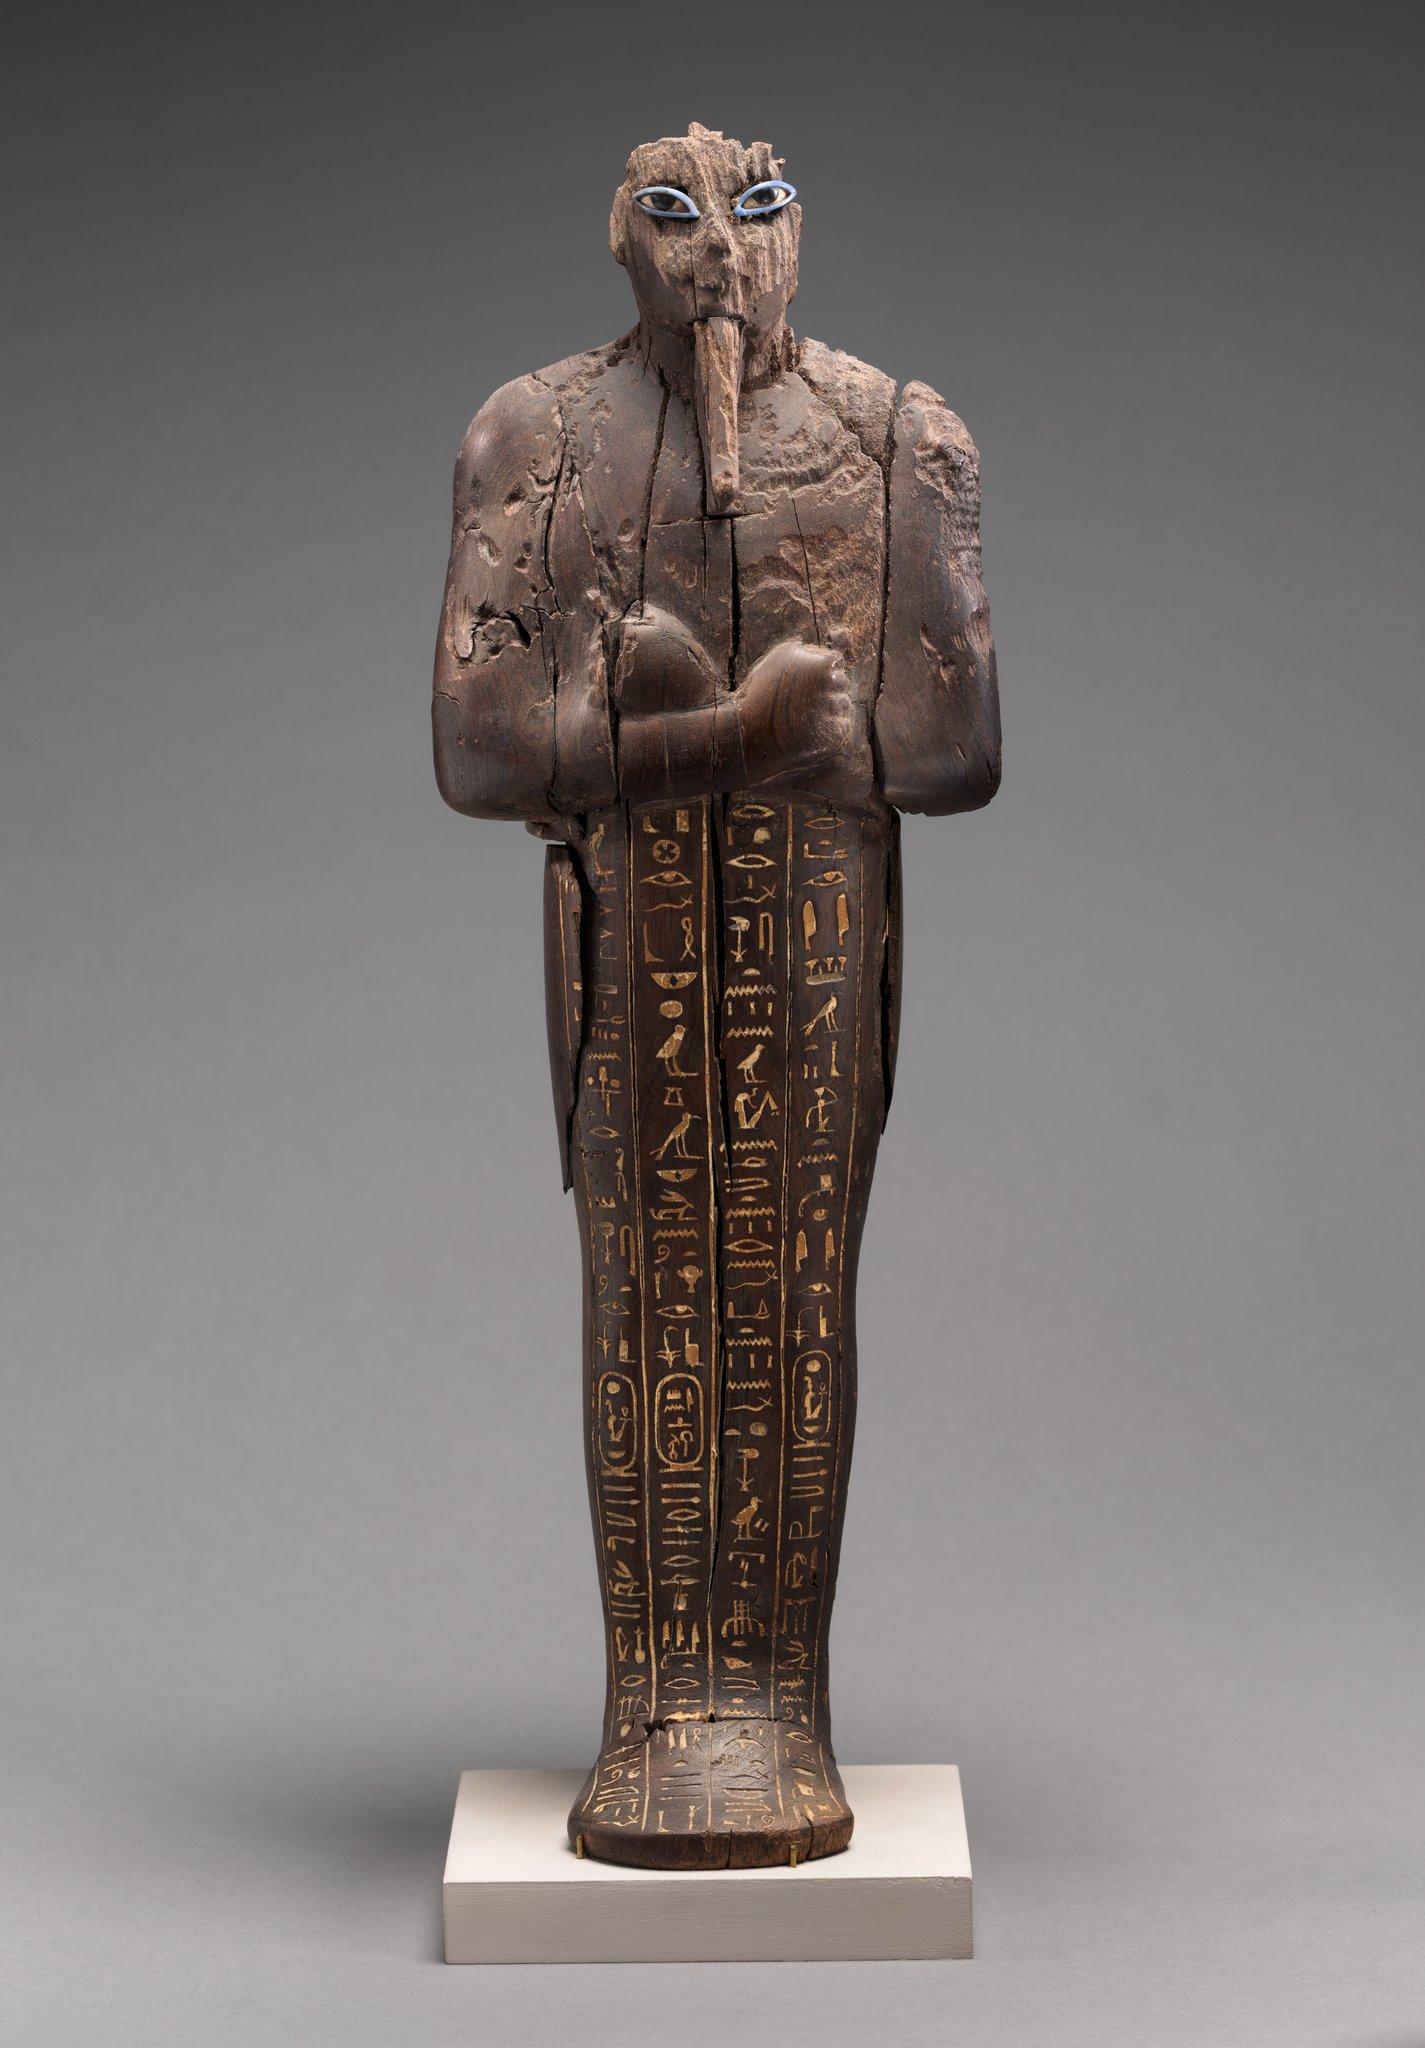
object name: shabti, amenhotep iii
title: Shabti of Amenhotep III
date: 1390-1352 BCE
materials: wood, glass, pigment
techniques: inlay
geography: egypt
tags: hieroglyphs